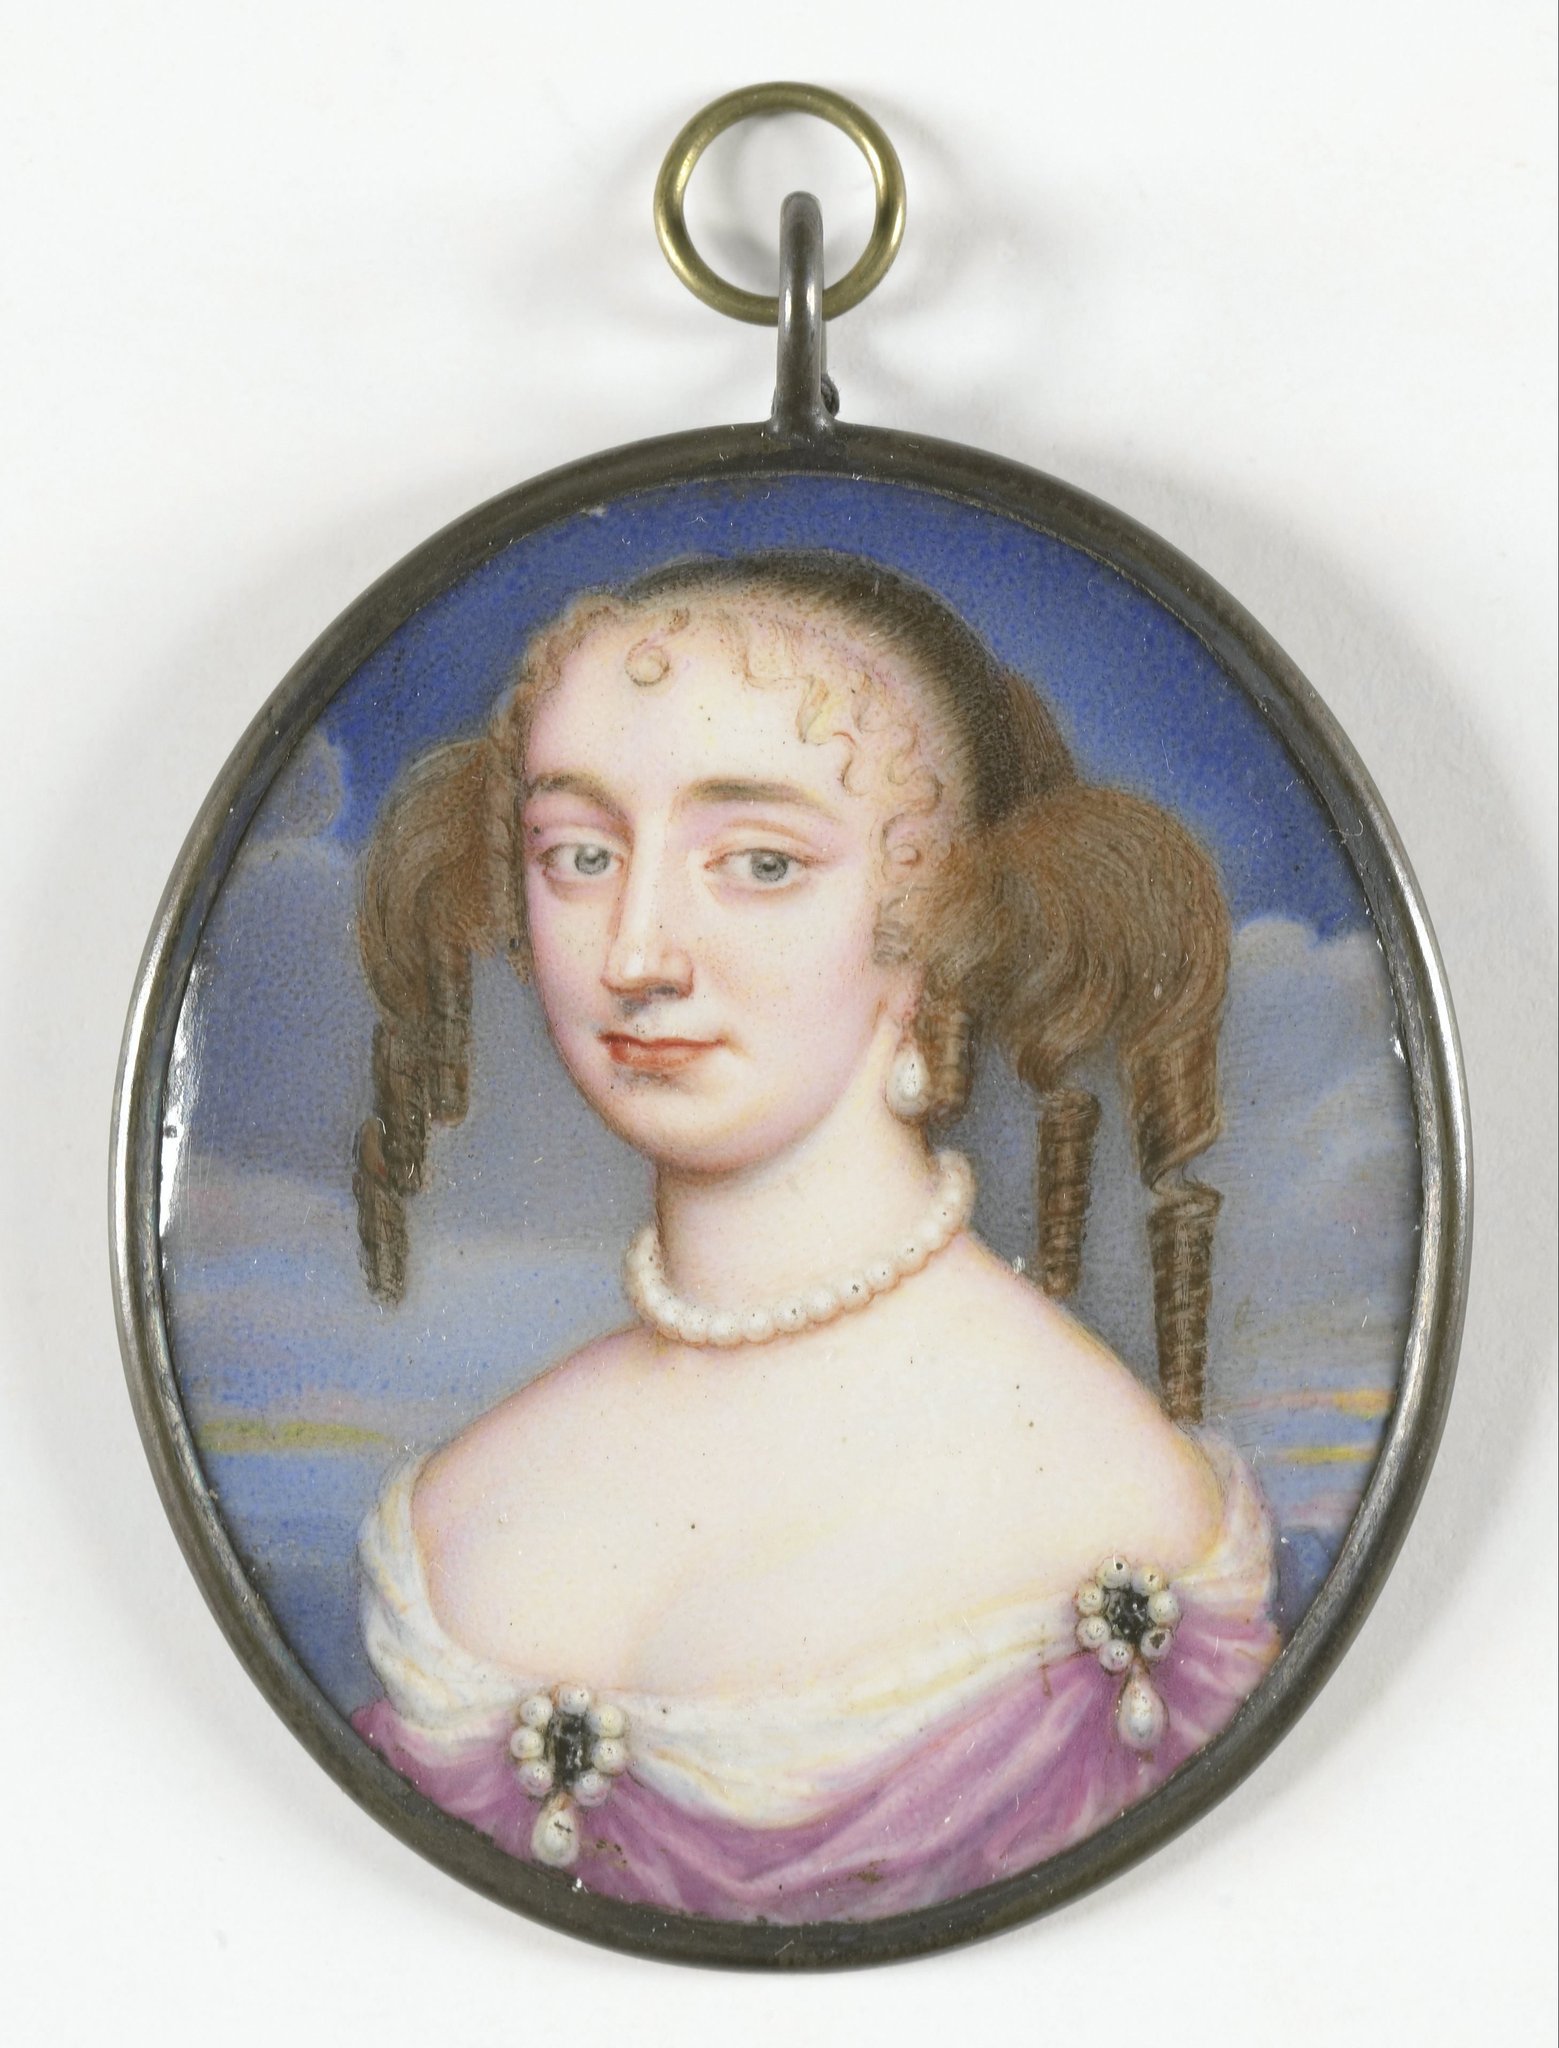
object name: painting, miniature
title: Portret van een vrouw, misschien Anne Hyde (1637-71), eerste echtgenote van Jacobus II van Engeland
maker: Anonymous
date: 1662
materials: copper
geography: england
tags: anna hyde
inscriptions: inscription: ‘[monogram] DL [of LD] 1662’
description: Portret van een vrouw, misschien Anne Hyde (1637-71), eerste echtgenote van Jacobus II van Engeland. Buste naar links, aanziend. Onderdeel van de collectie portretminiaturen.